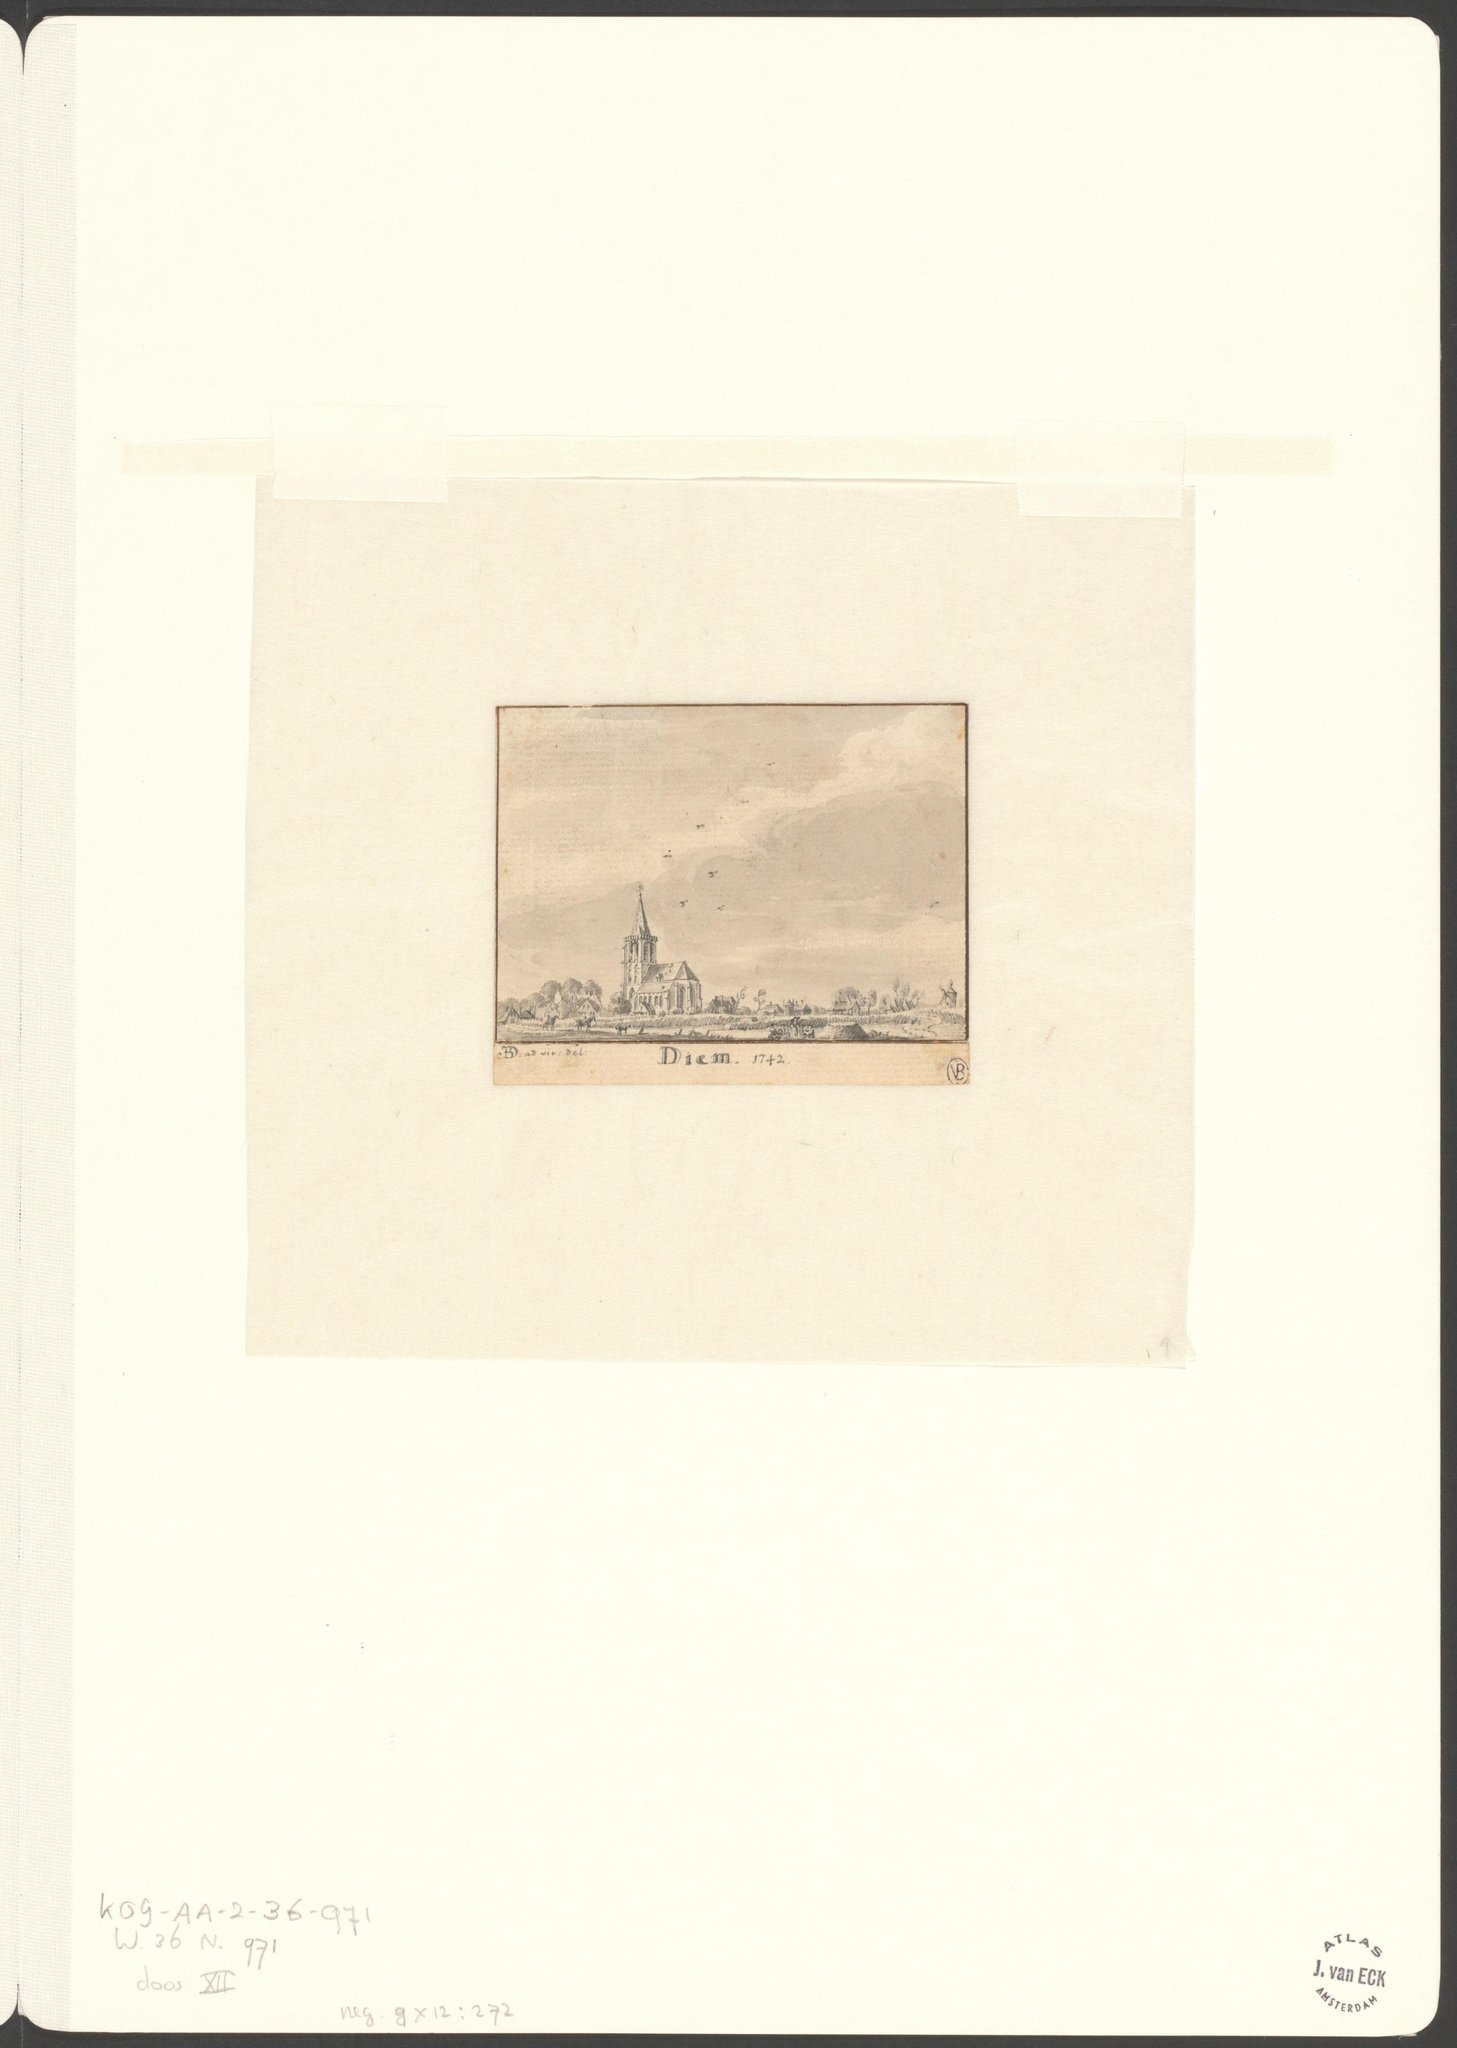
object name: drawing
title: Gezicht op de Sint Petrusbandenkerk in Diemen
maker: jan de beijer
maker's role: draughtsman, print maker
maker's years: 1703-1780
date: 1742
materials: ink, paper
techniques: brush, pen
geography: diemen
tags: village, parts of church exterior and annexes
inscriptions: collector's mark: Lugt 800a, collector's mark: Lugt 2505, signature and date: ‘JDB: ad viv: del: / Diem. 1742.’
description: Tekening binnen de Atlas Van Eck ingedeeld op wijknummer 36.